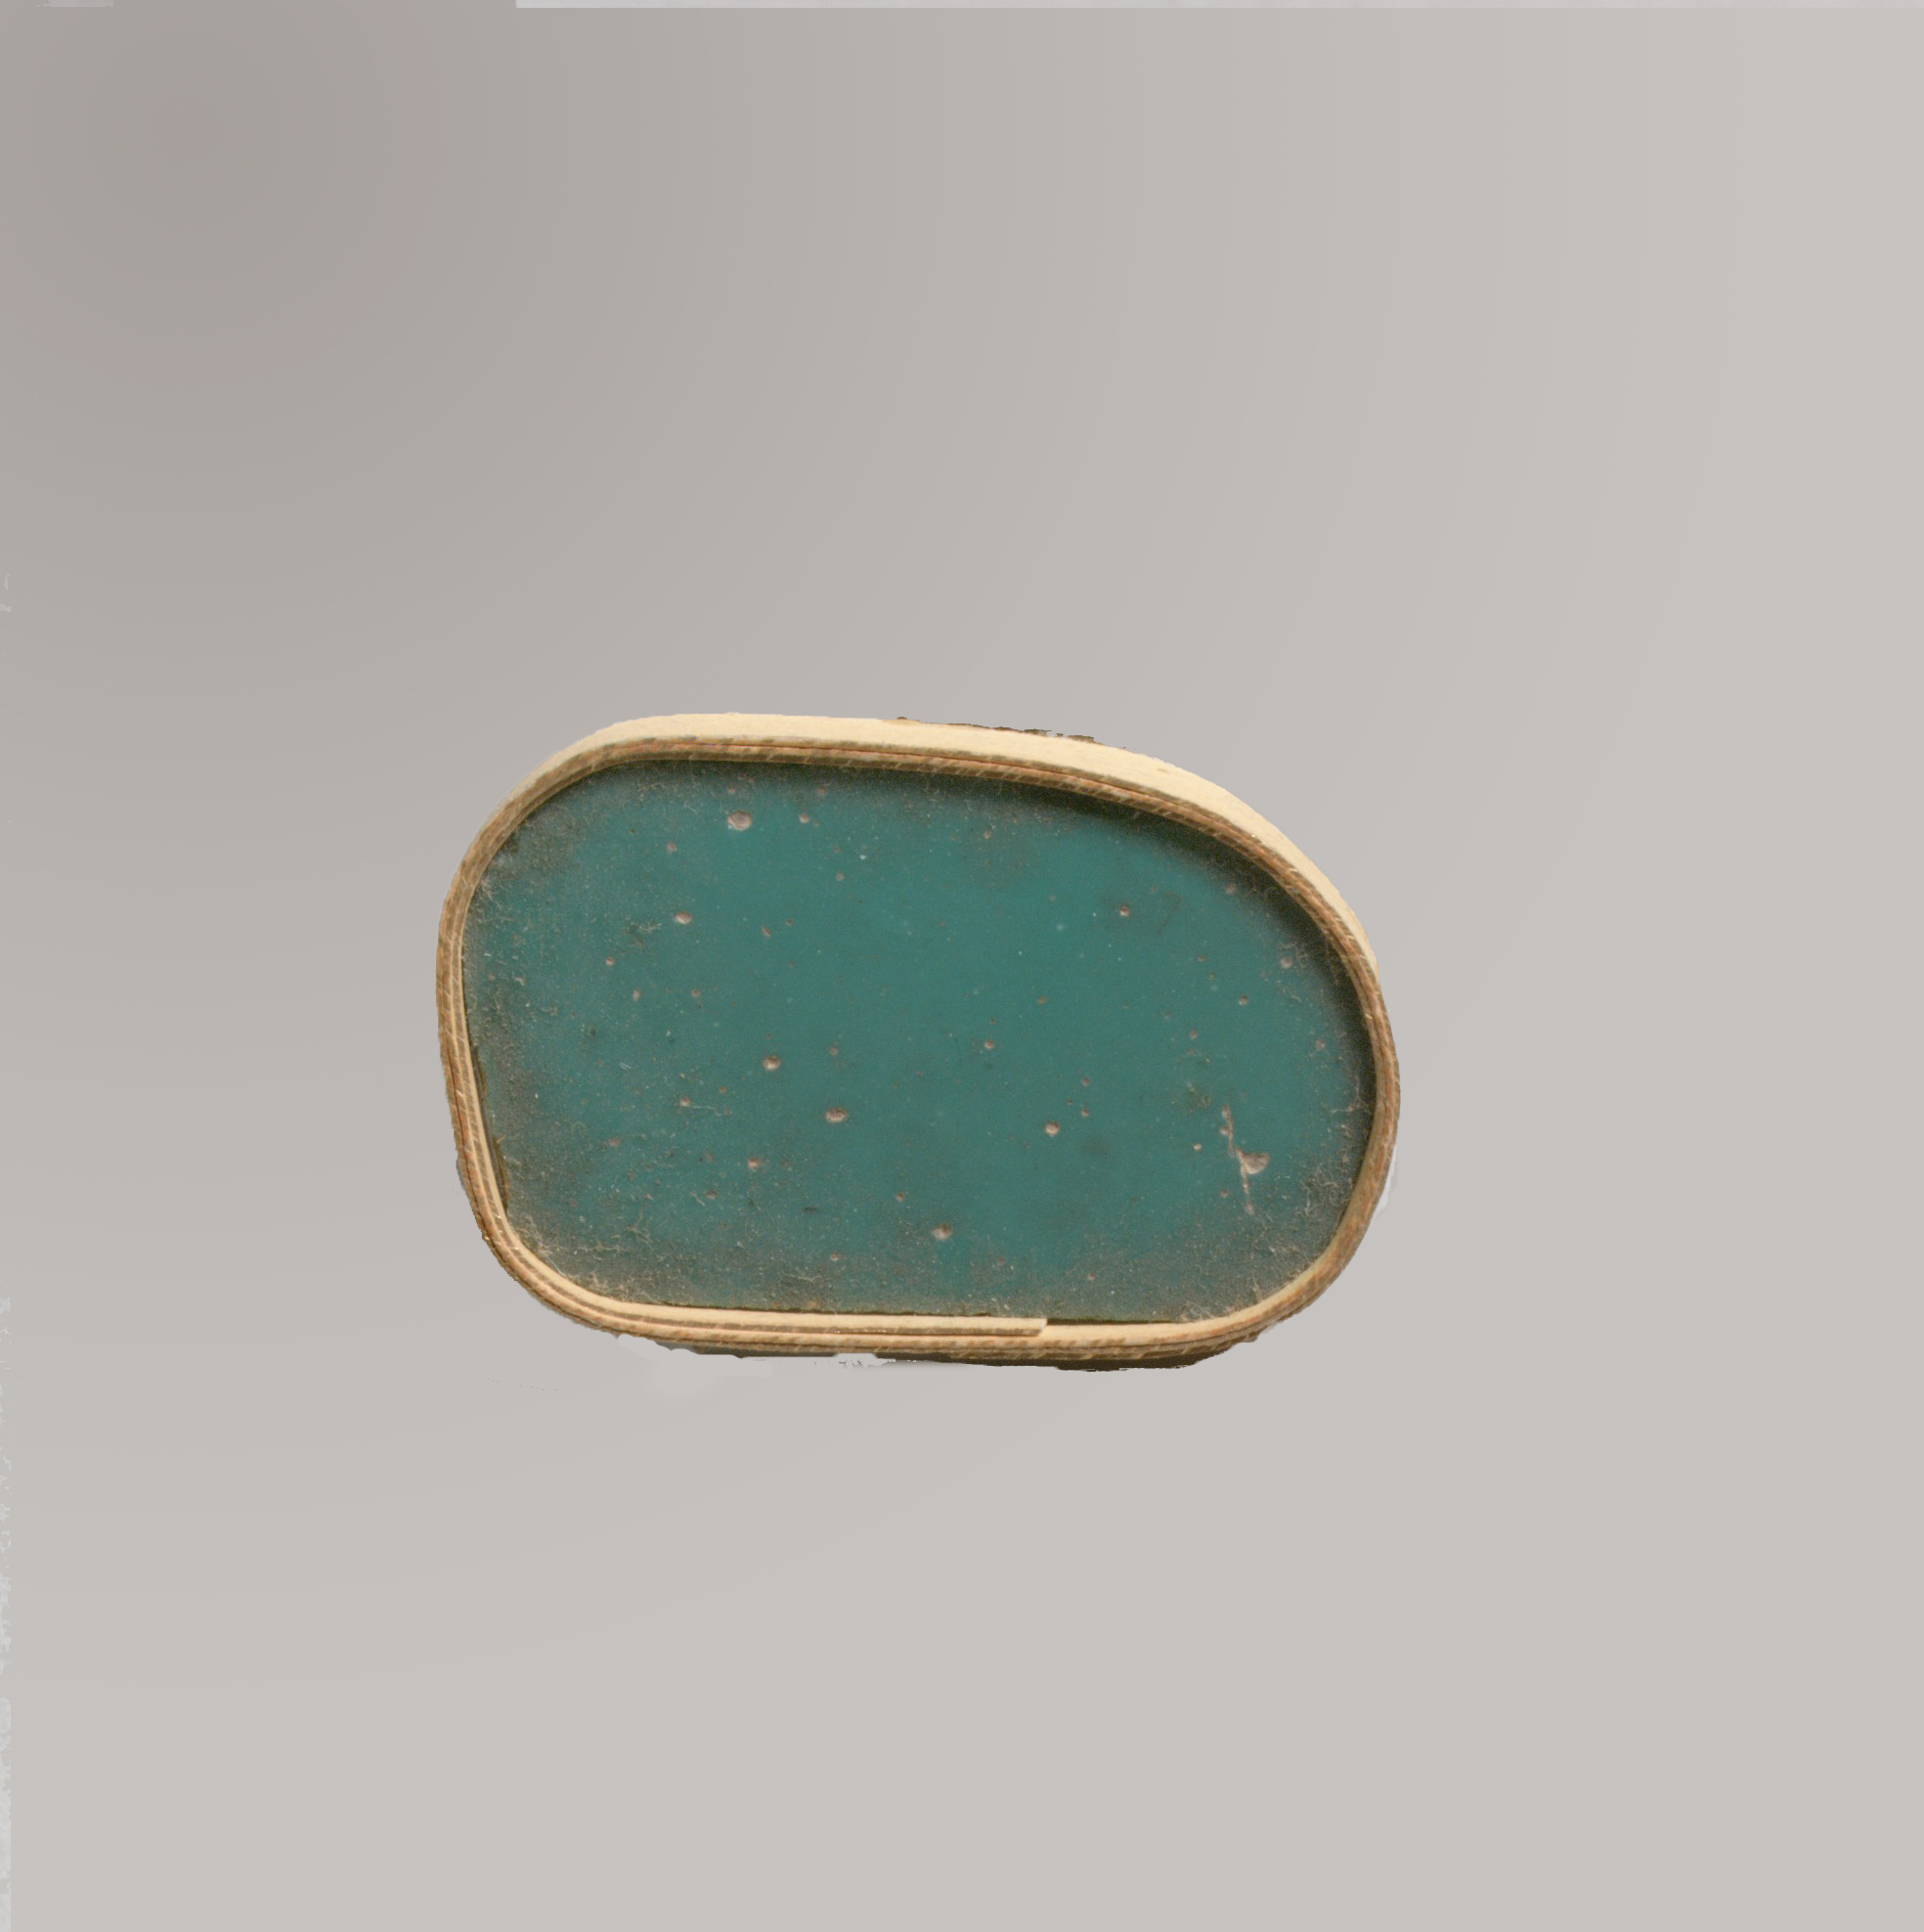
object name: fragment, monochrome inlay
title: Glass monochrome inlay fragment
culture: roman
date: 1-50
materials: glass